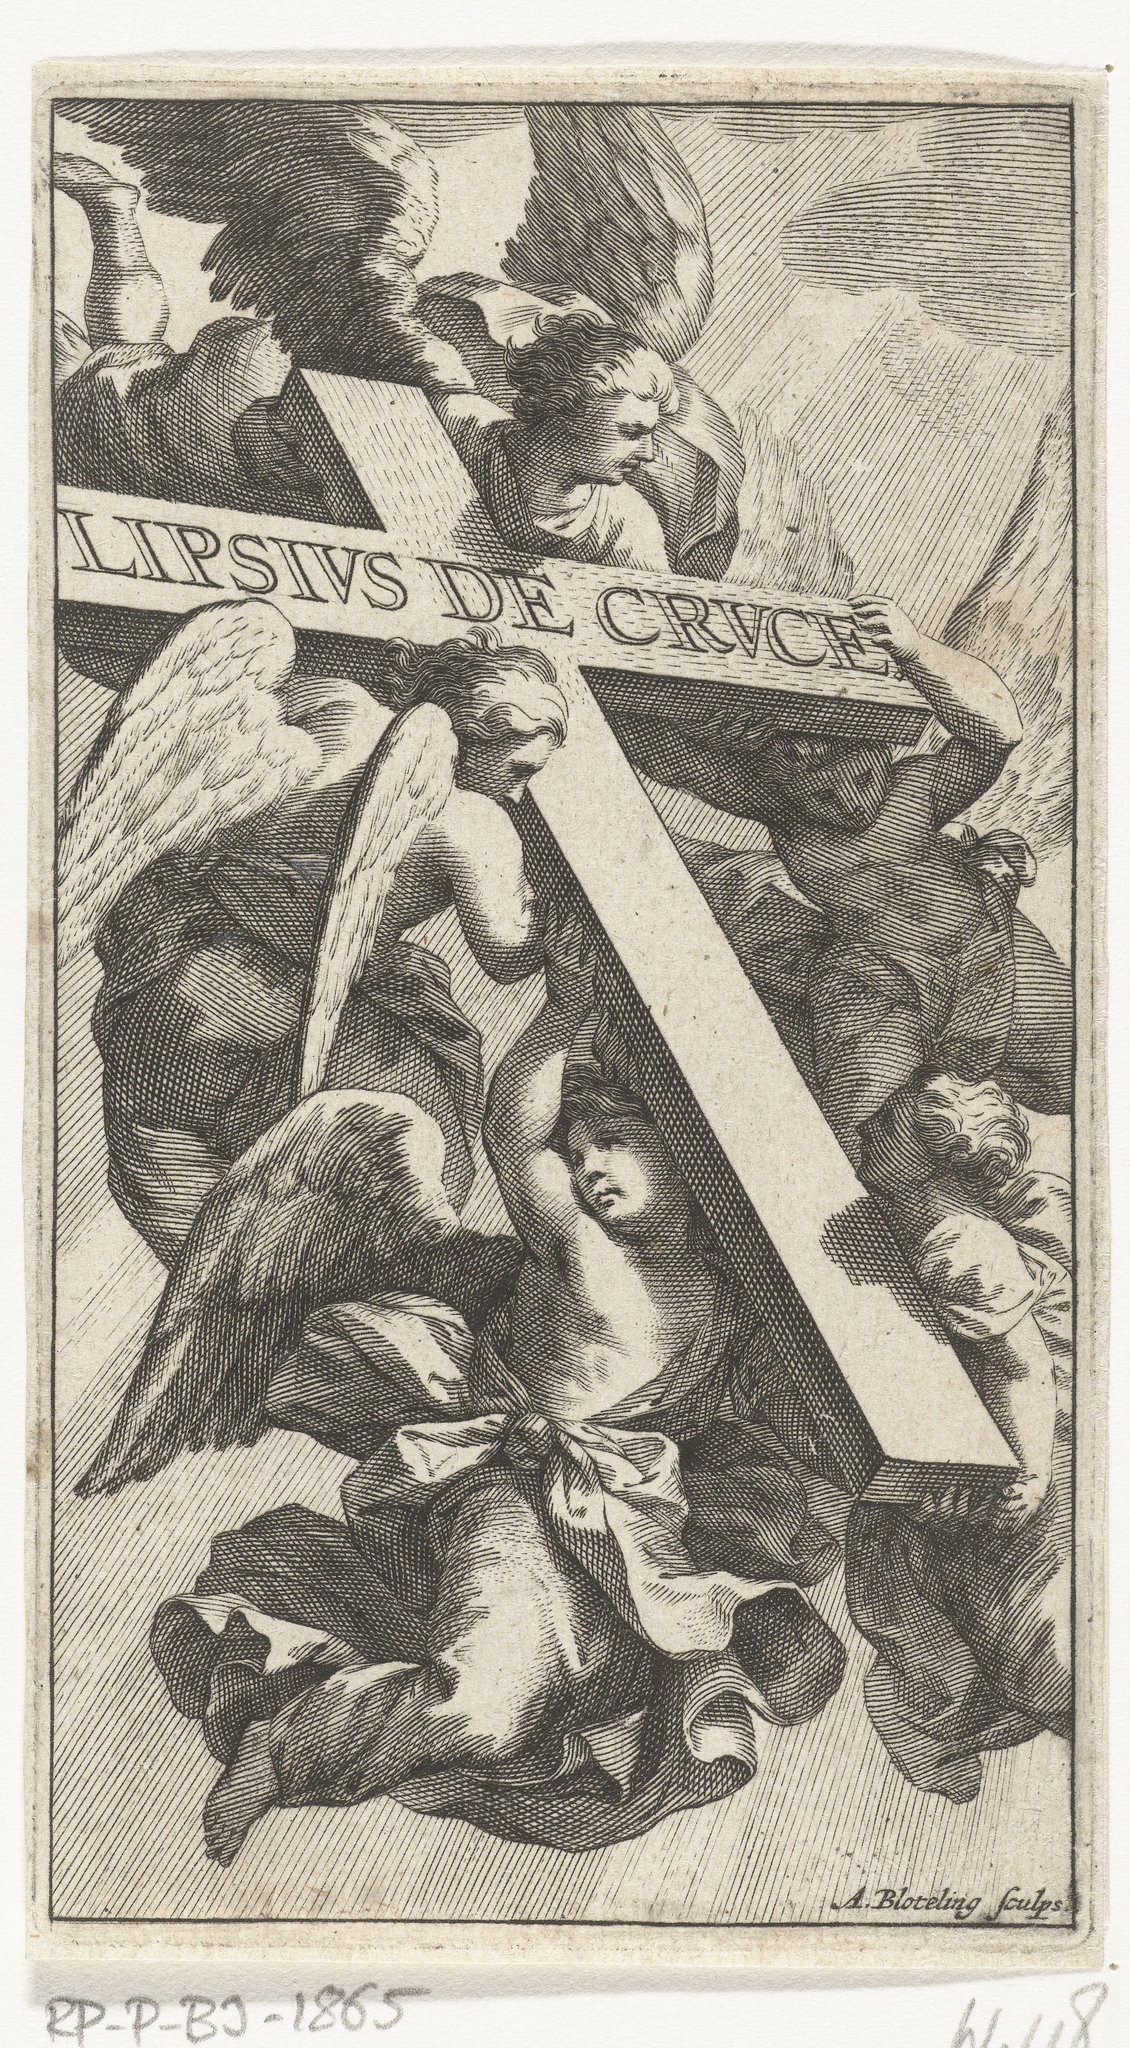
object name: titelblad, titelpagina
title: Titelpagina voor: Justus Lipsius, De crvce libri tres. Amsterdam, 1670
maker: abraham bloteling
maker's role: draughtsman, print maker, publisher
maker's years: 1640-1690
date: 1670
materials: paper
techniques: engraving, etching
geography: amsterdam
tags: specific forms of the cross (+ angel(s))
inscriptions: collector's mark: Lugt 2228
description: Een aantal engelen dragen een kruis met het opschrift: Lipsivs de Crvce.